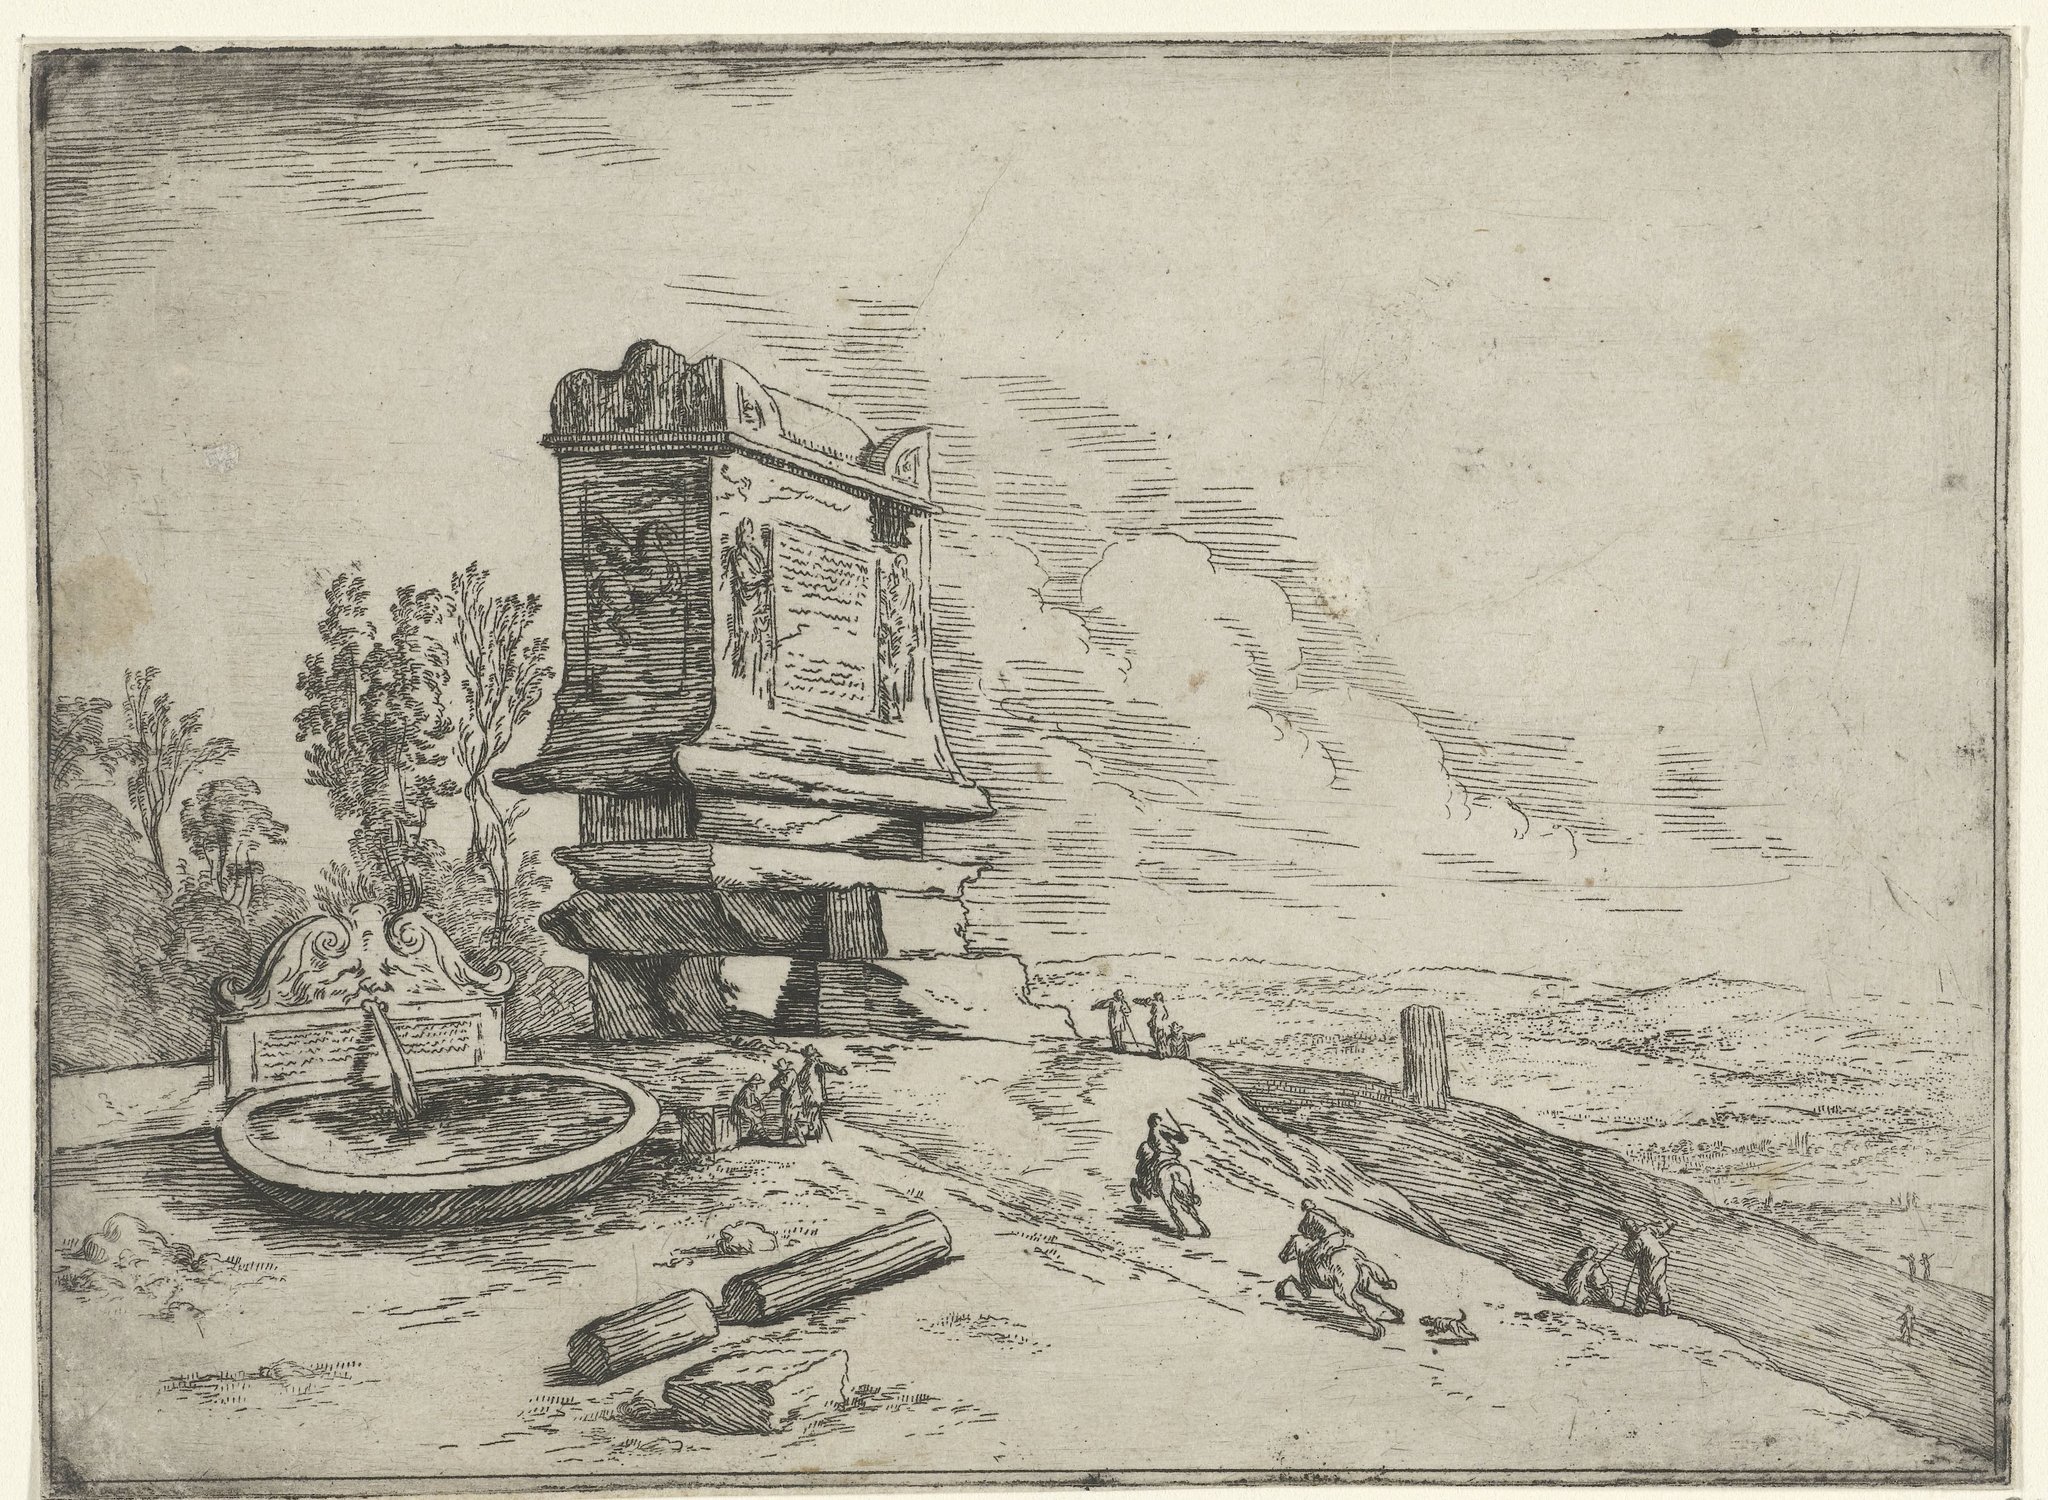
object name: print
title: Landschap met een sarcofaag en een fontein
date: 1647-1674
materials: paper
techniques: etching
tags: landscape with ruins, sarcophagus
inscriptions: collector's mark: Lugt 12, collector's mark: Lugt 573